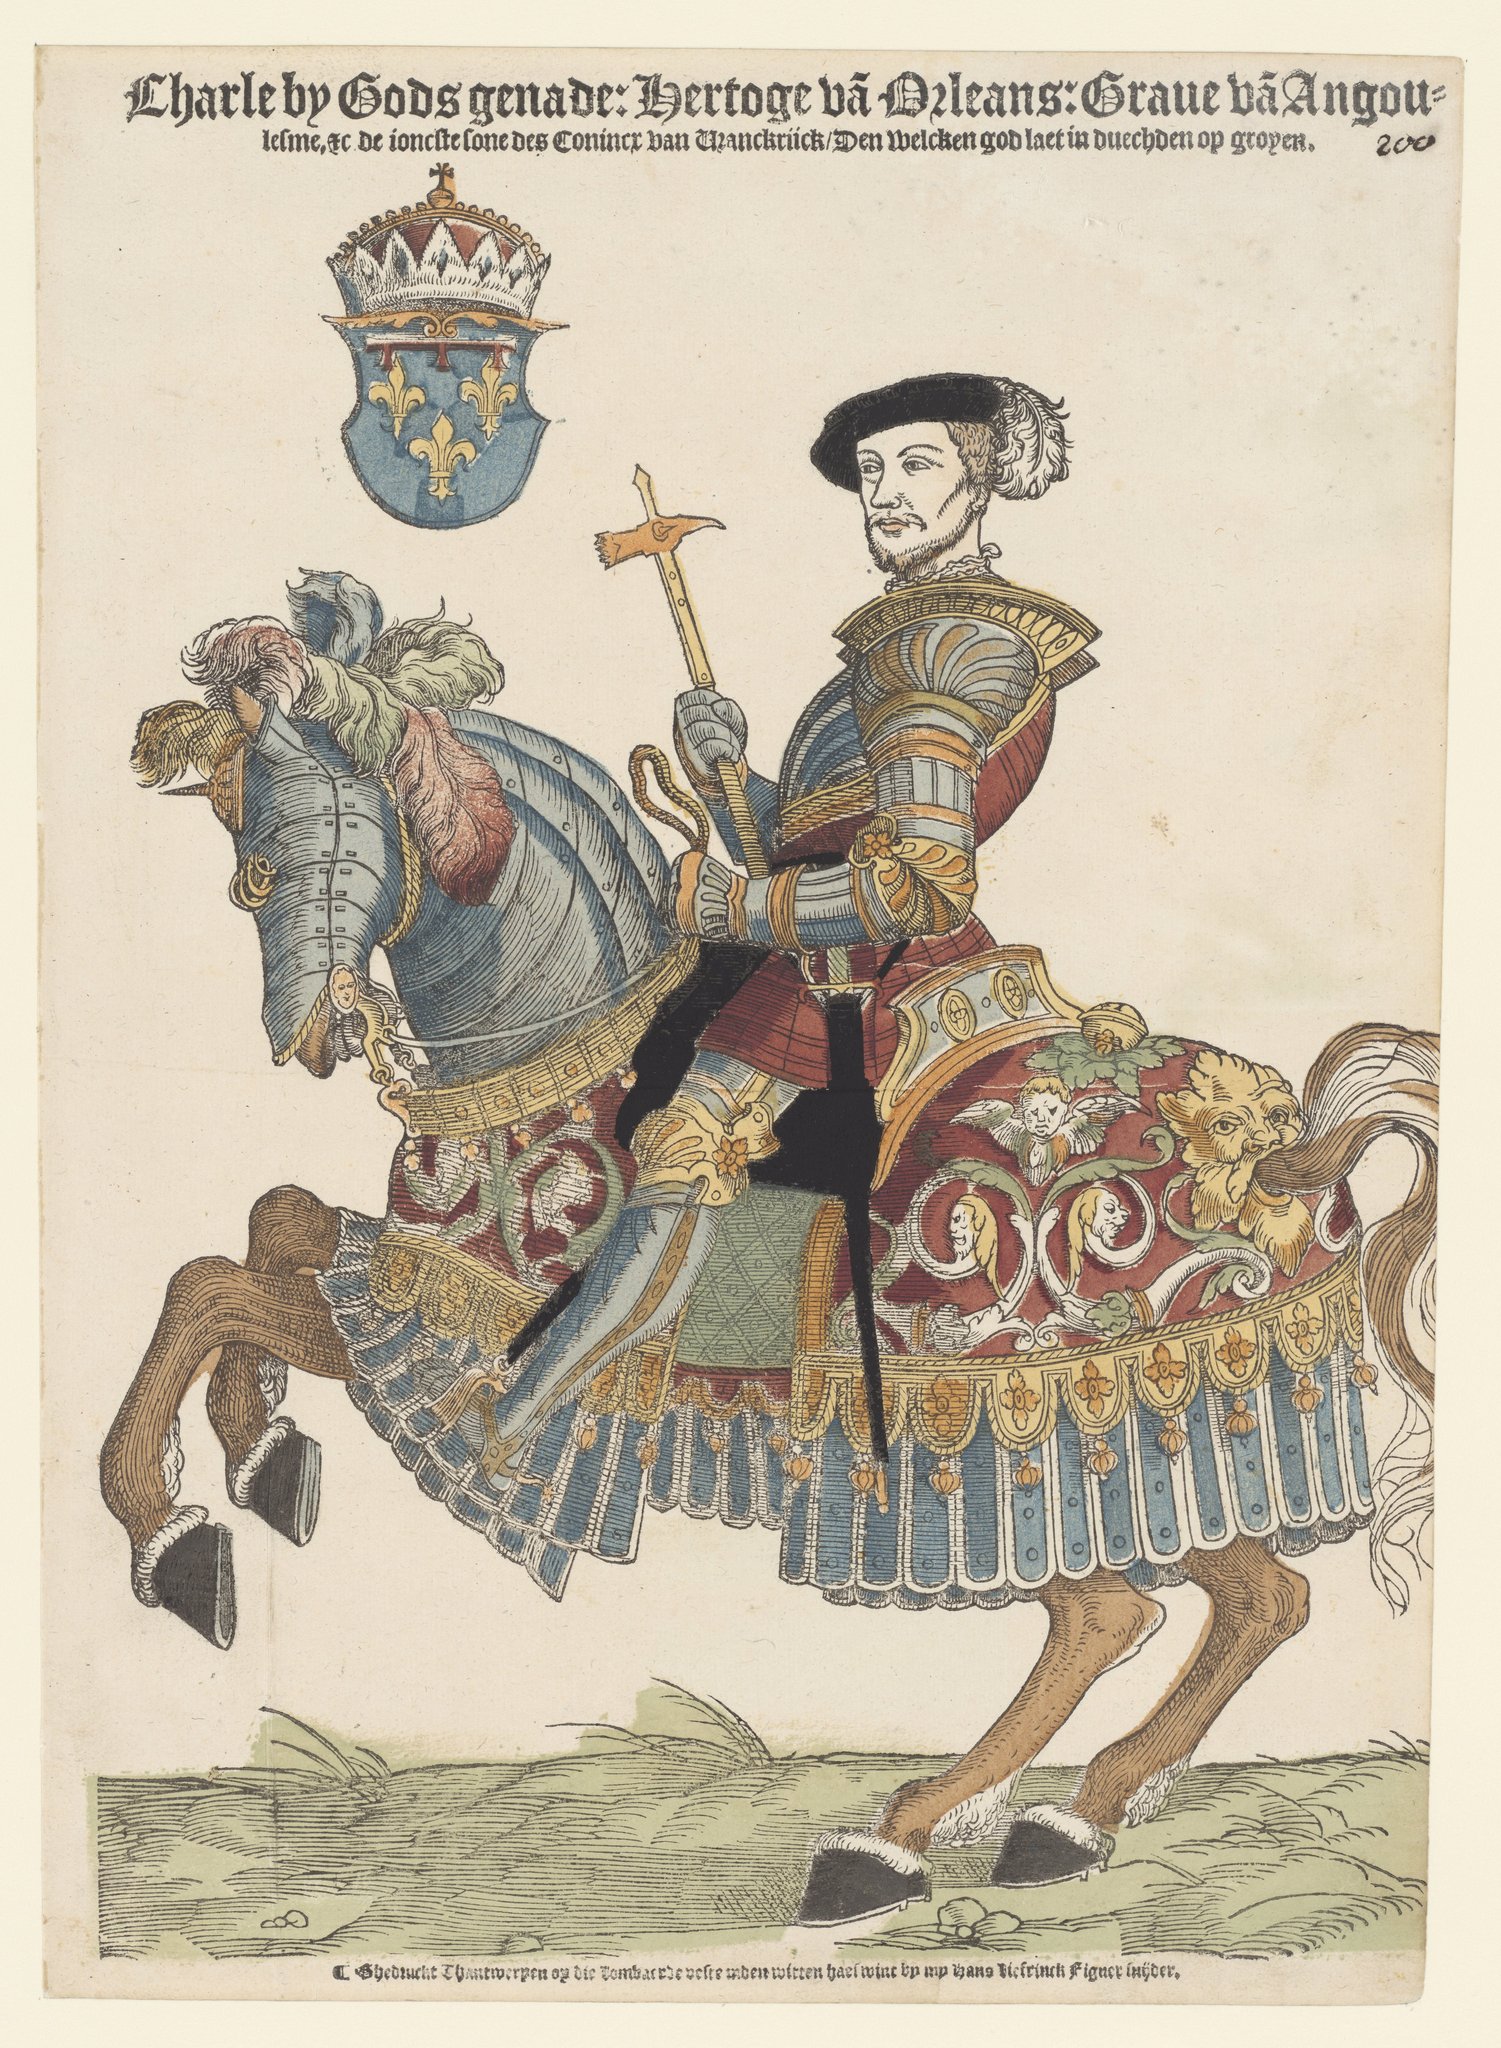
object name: print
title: Portret van Karel van Orléans te paard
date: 1539-1545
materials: paper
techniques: hand coloring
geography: antwerp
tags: equestrian state-portrait, historical persons, king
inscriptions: address: ‘Ghedruckt Thantwerpen op die Lombaerde veste inden witten haesewint by myn Hans Liefrinck Figuer snijder.’, number: ‘200’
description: Karel van Orléans (1522-1545), derde en jongste zoon van Frans I, kreeg in 1536 de titel 'hertog van Orléans'. Hij huwde in 1539 Maria, de oudste dochter van Karel V. Zij zouden het bestuur van de Nederlanden overnemen van de landvoogdes Maria van Hongarije. Karel van Orleans is afgebeeld als een ruiter in volle wapenrusting, op een paard in galop naar links. Linksboven het wapen van Frankrijk met de hertogkroon, gebroken door de barensteel als jongere zoon.